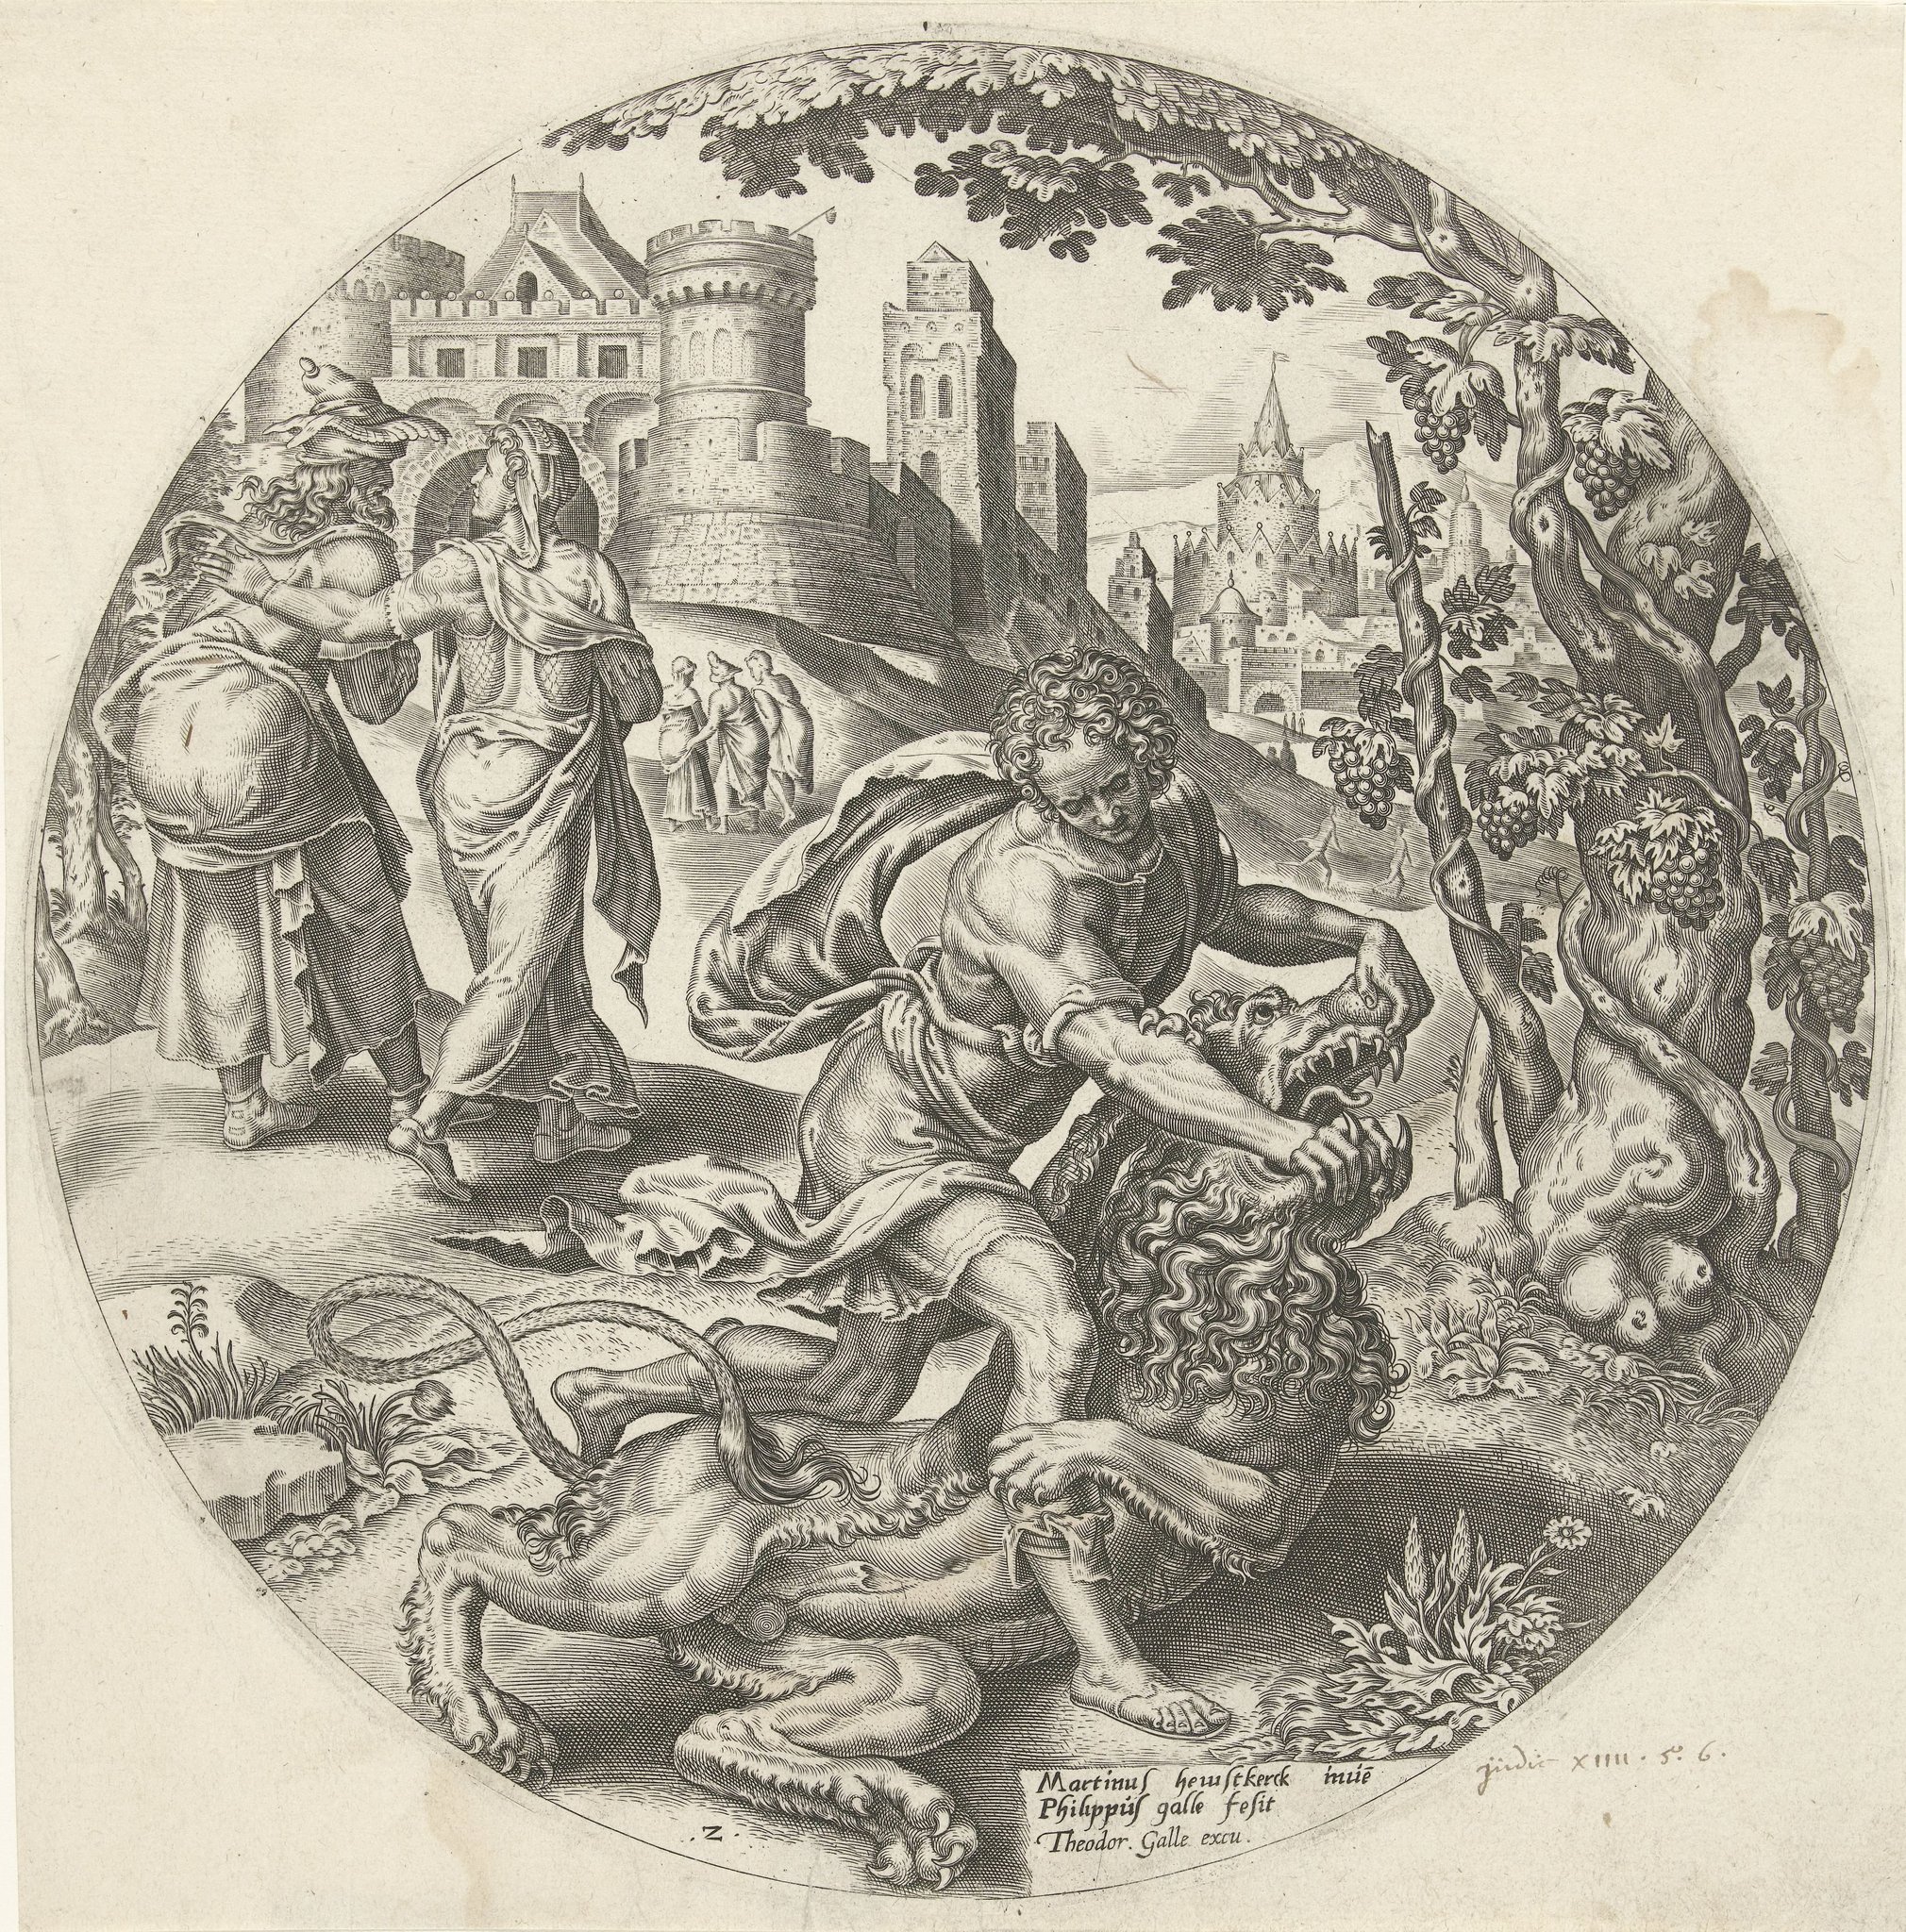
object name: print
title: Simson doodt de leeuw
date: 1596-1633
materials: paper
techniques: engraving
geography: haarlem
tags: samson kills the lion with his bare hands, samson and his parents on their journey to timnath, in the vineyards of timnath samson meets a roaring lion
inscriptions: collector's mark: Lugt 2228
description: Simson doodt bij de wijngaarden van Timna met zijn blote handen een leeuw, door de kaken van het dier uiteen te trekken. Links lopen de ouders van Simson met wie hij onderweg is naar Timna.